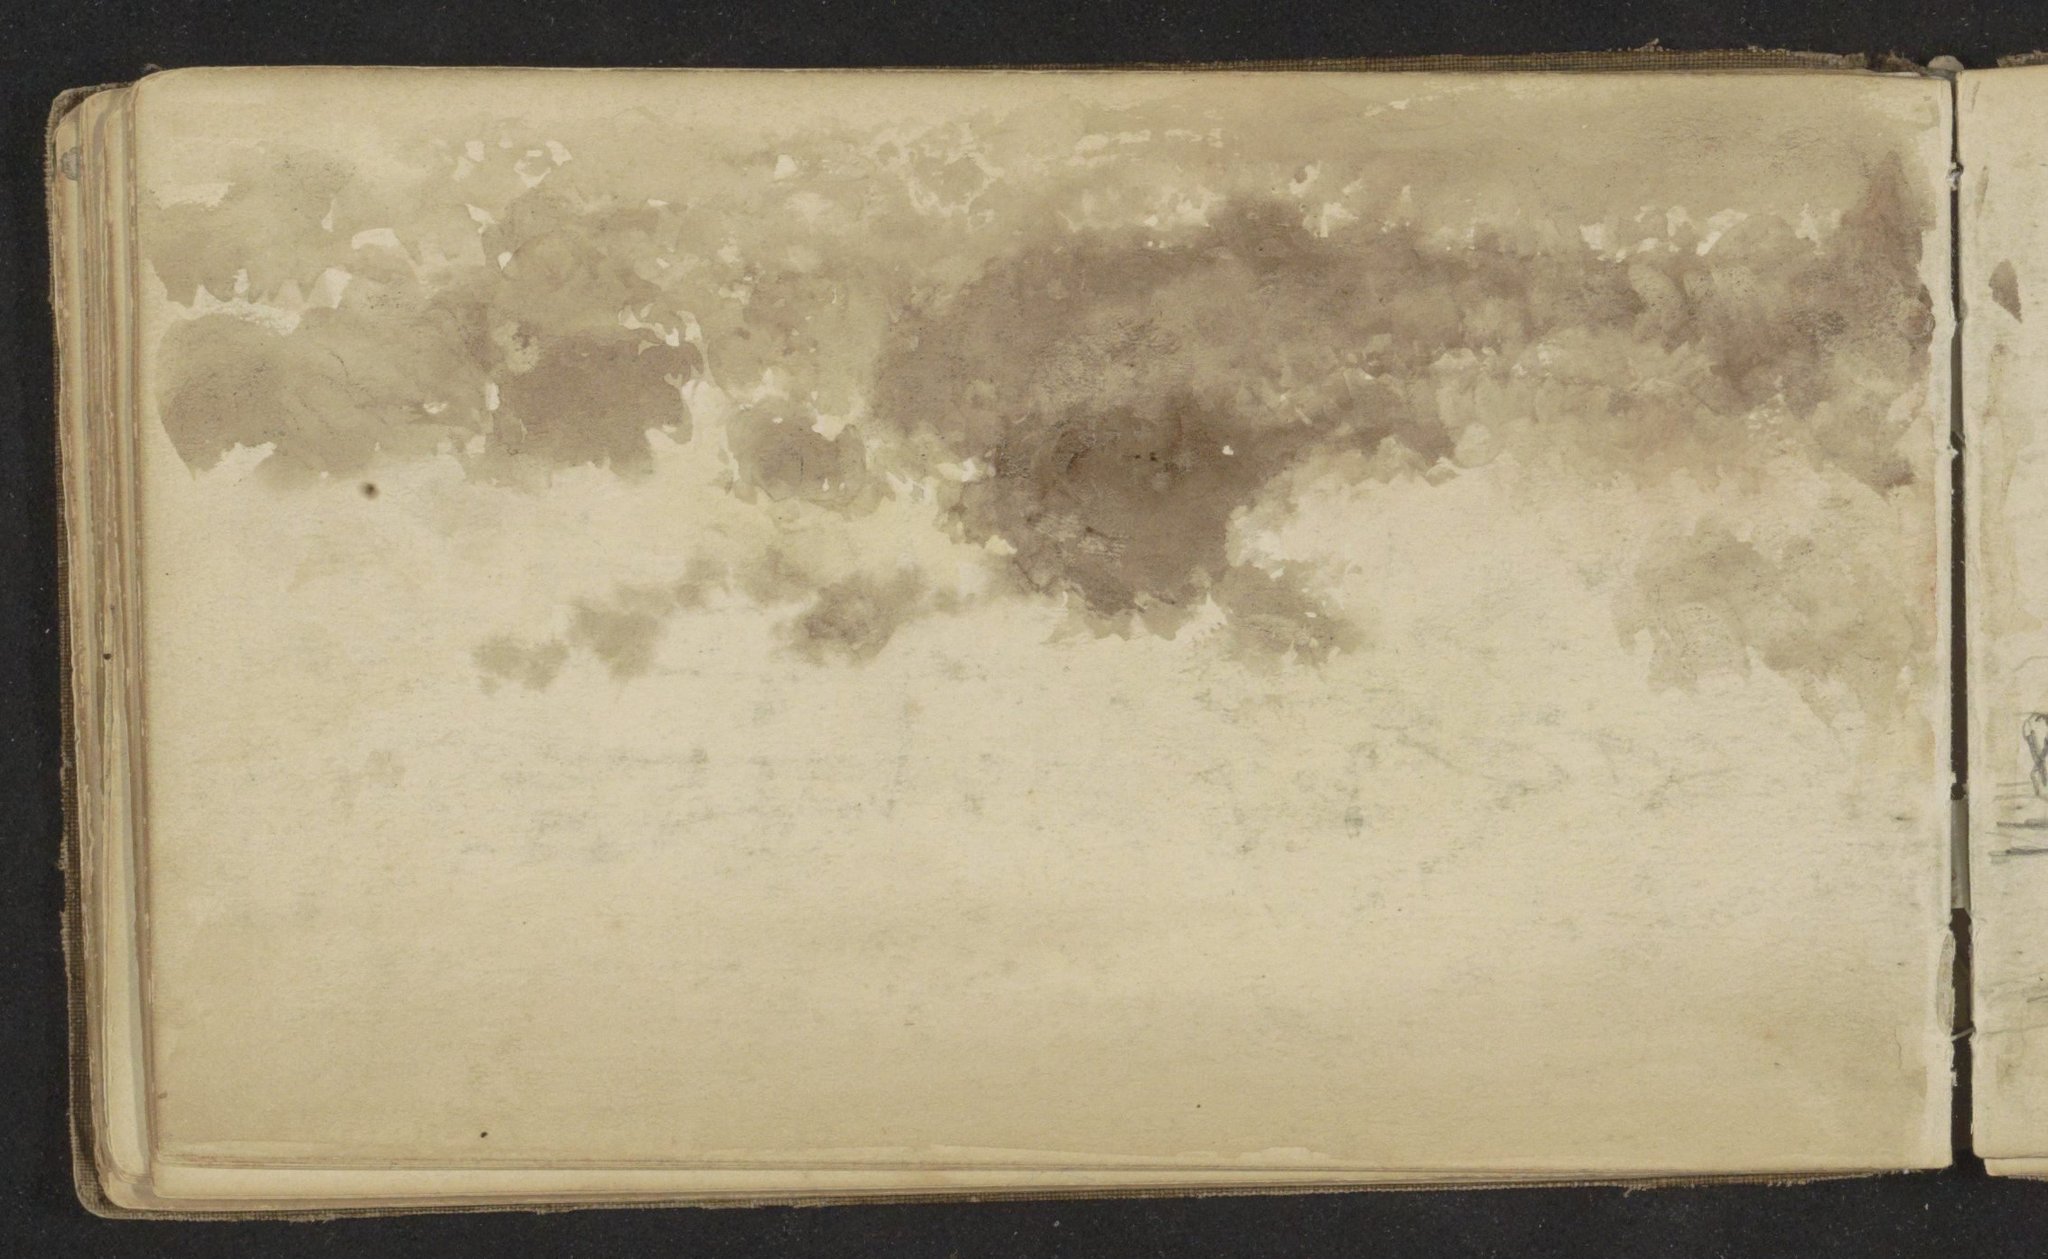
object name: sketchbook leaf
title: Landschap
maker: johan hendrik weissenbruch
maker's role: draughtsman, painter, print maker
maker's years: 1824-1903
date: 1834-1903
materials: paper, watercolor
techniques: brush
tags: landscapes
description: Blad 30 verso uit een schetsboek met 43 bladen.